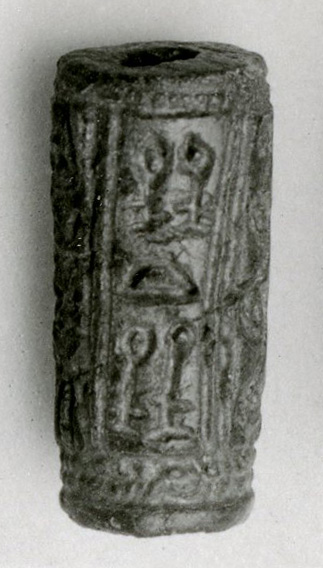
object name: cylinder seal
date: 1640-1550 BCE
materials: stone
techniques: glazing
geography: egypt